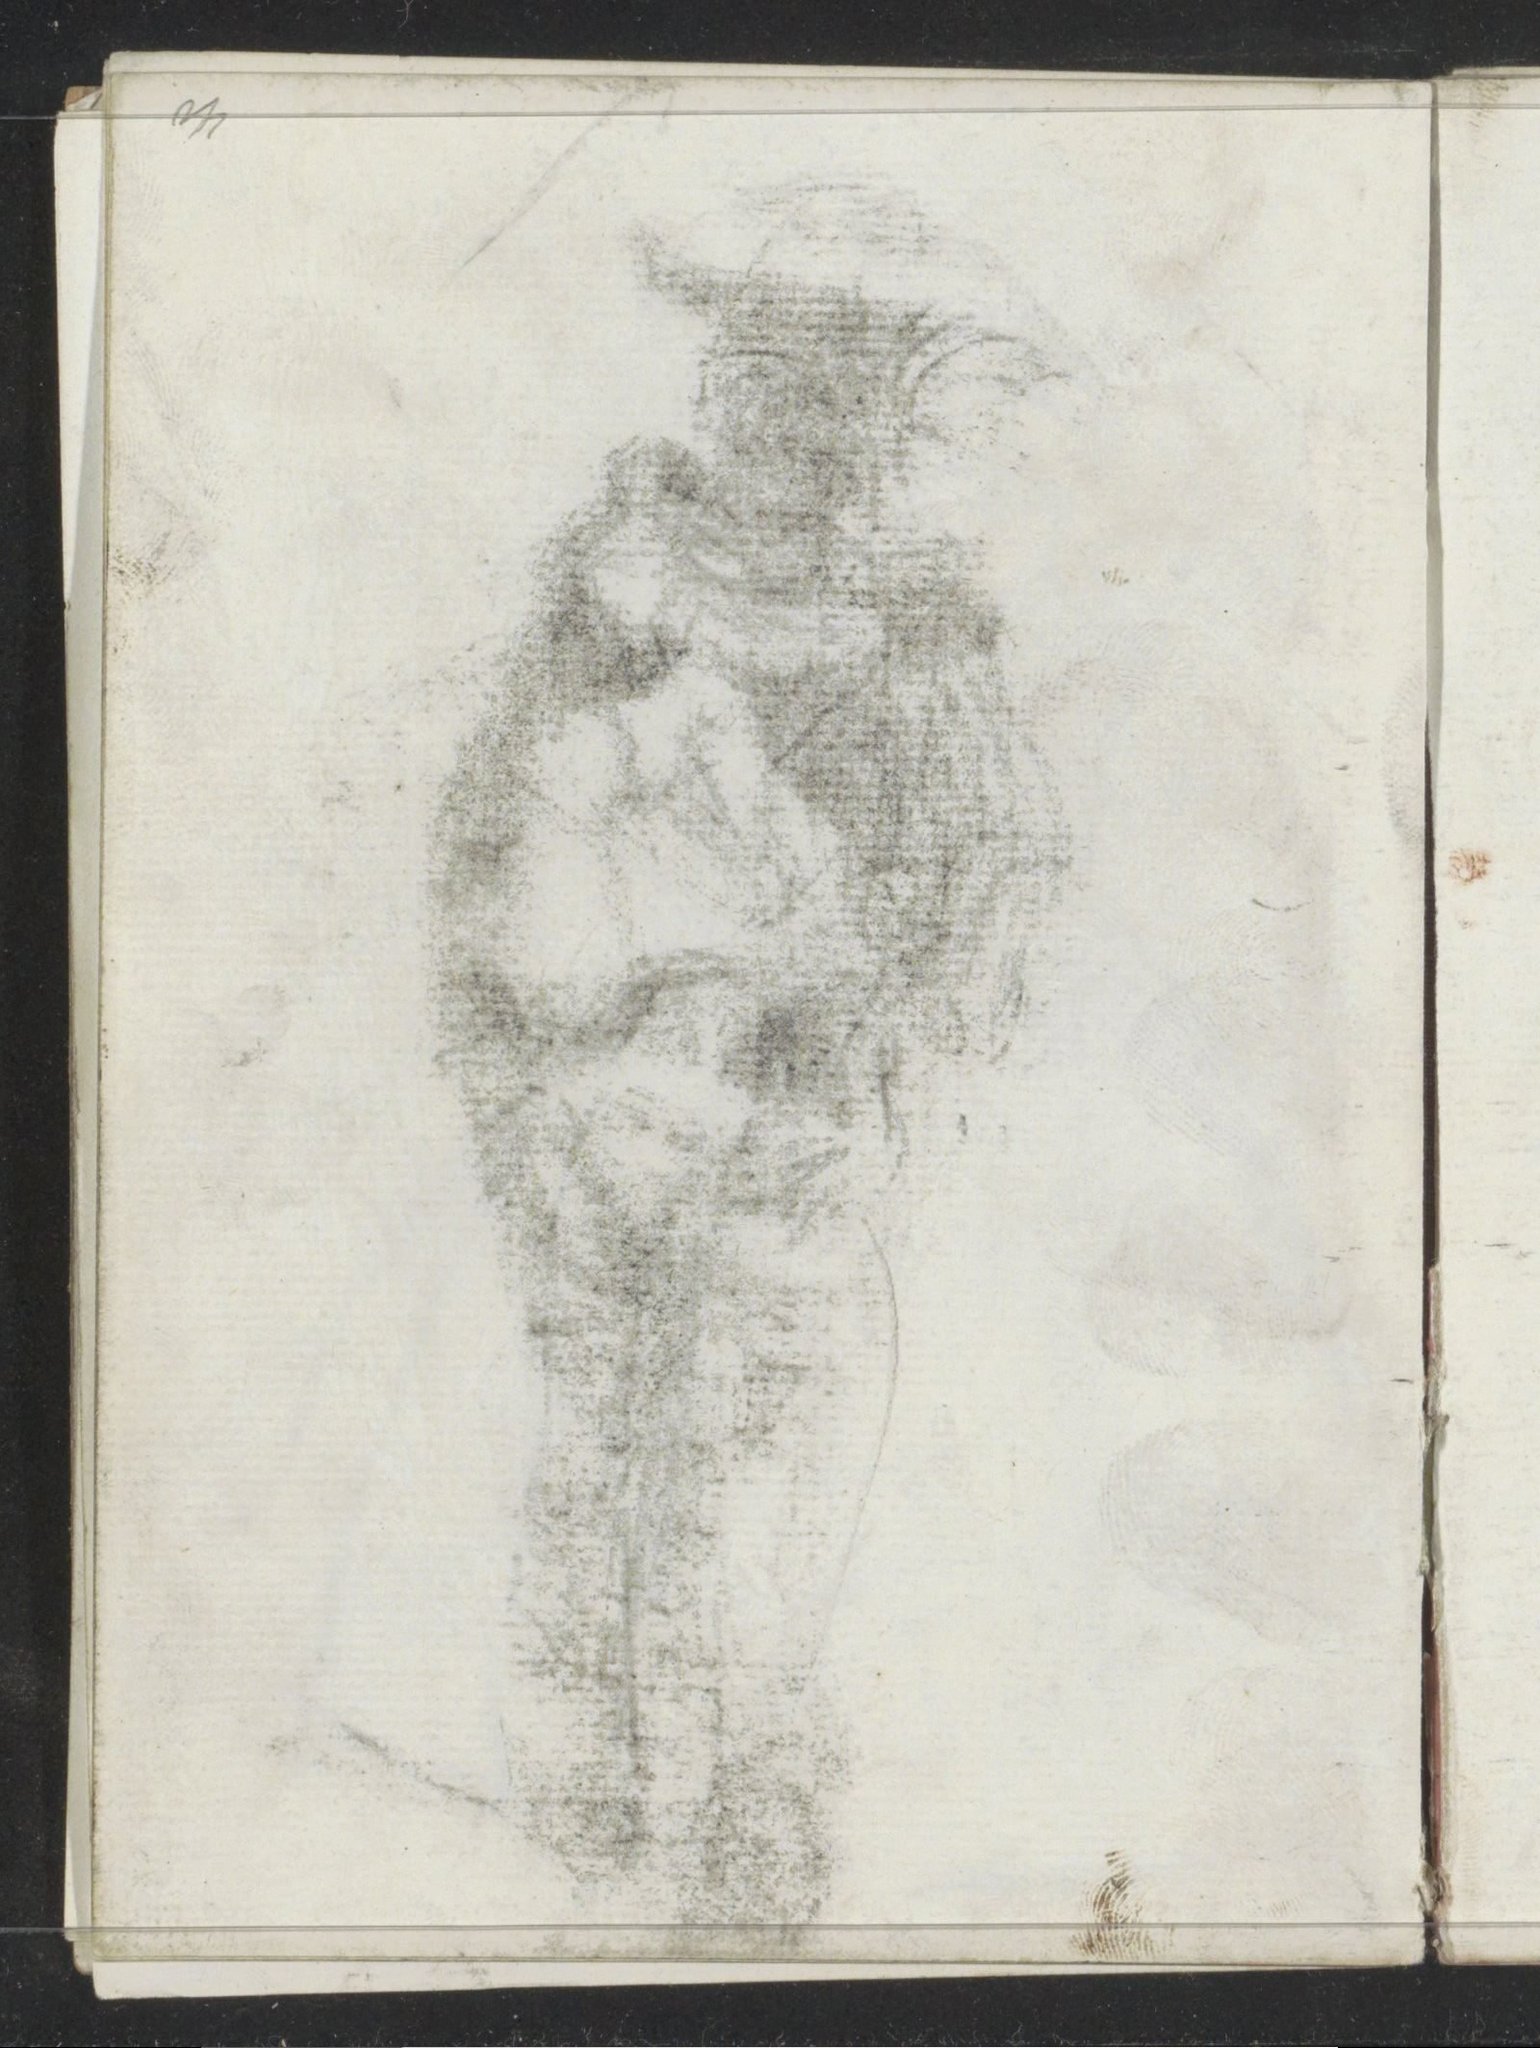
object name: sketchbook leaf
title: Abklatsch van de krijttekening op blad 8 recto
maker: isaac israels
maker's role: draughtsman, painter, print maker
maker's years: 1865-1934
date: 1886-1934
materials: paper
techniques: printmaking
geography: amsterdam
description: Blad 7 verso uit schetsboek LXIII met 23 bladen.